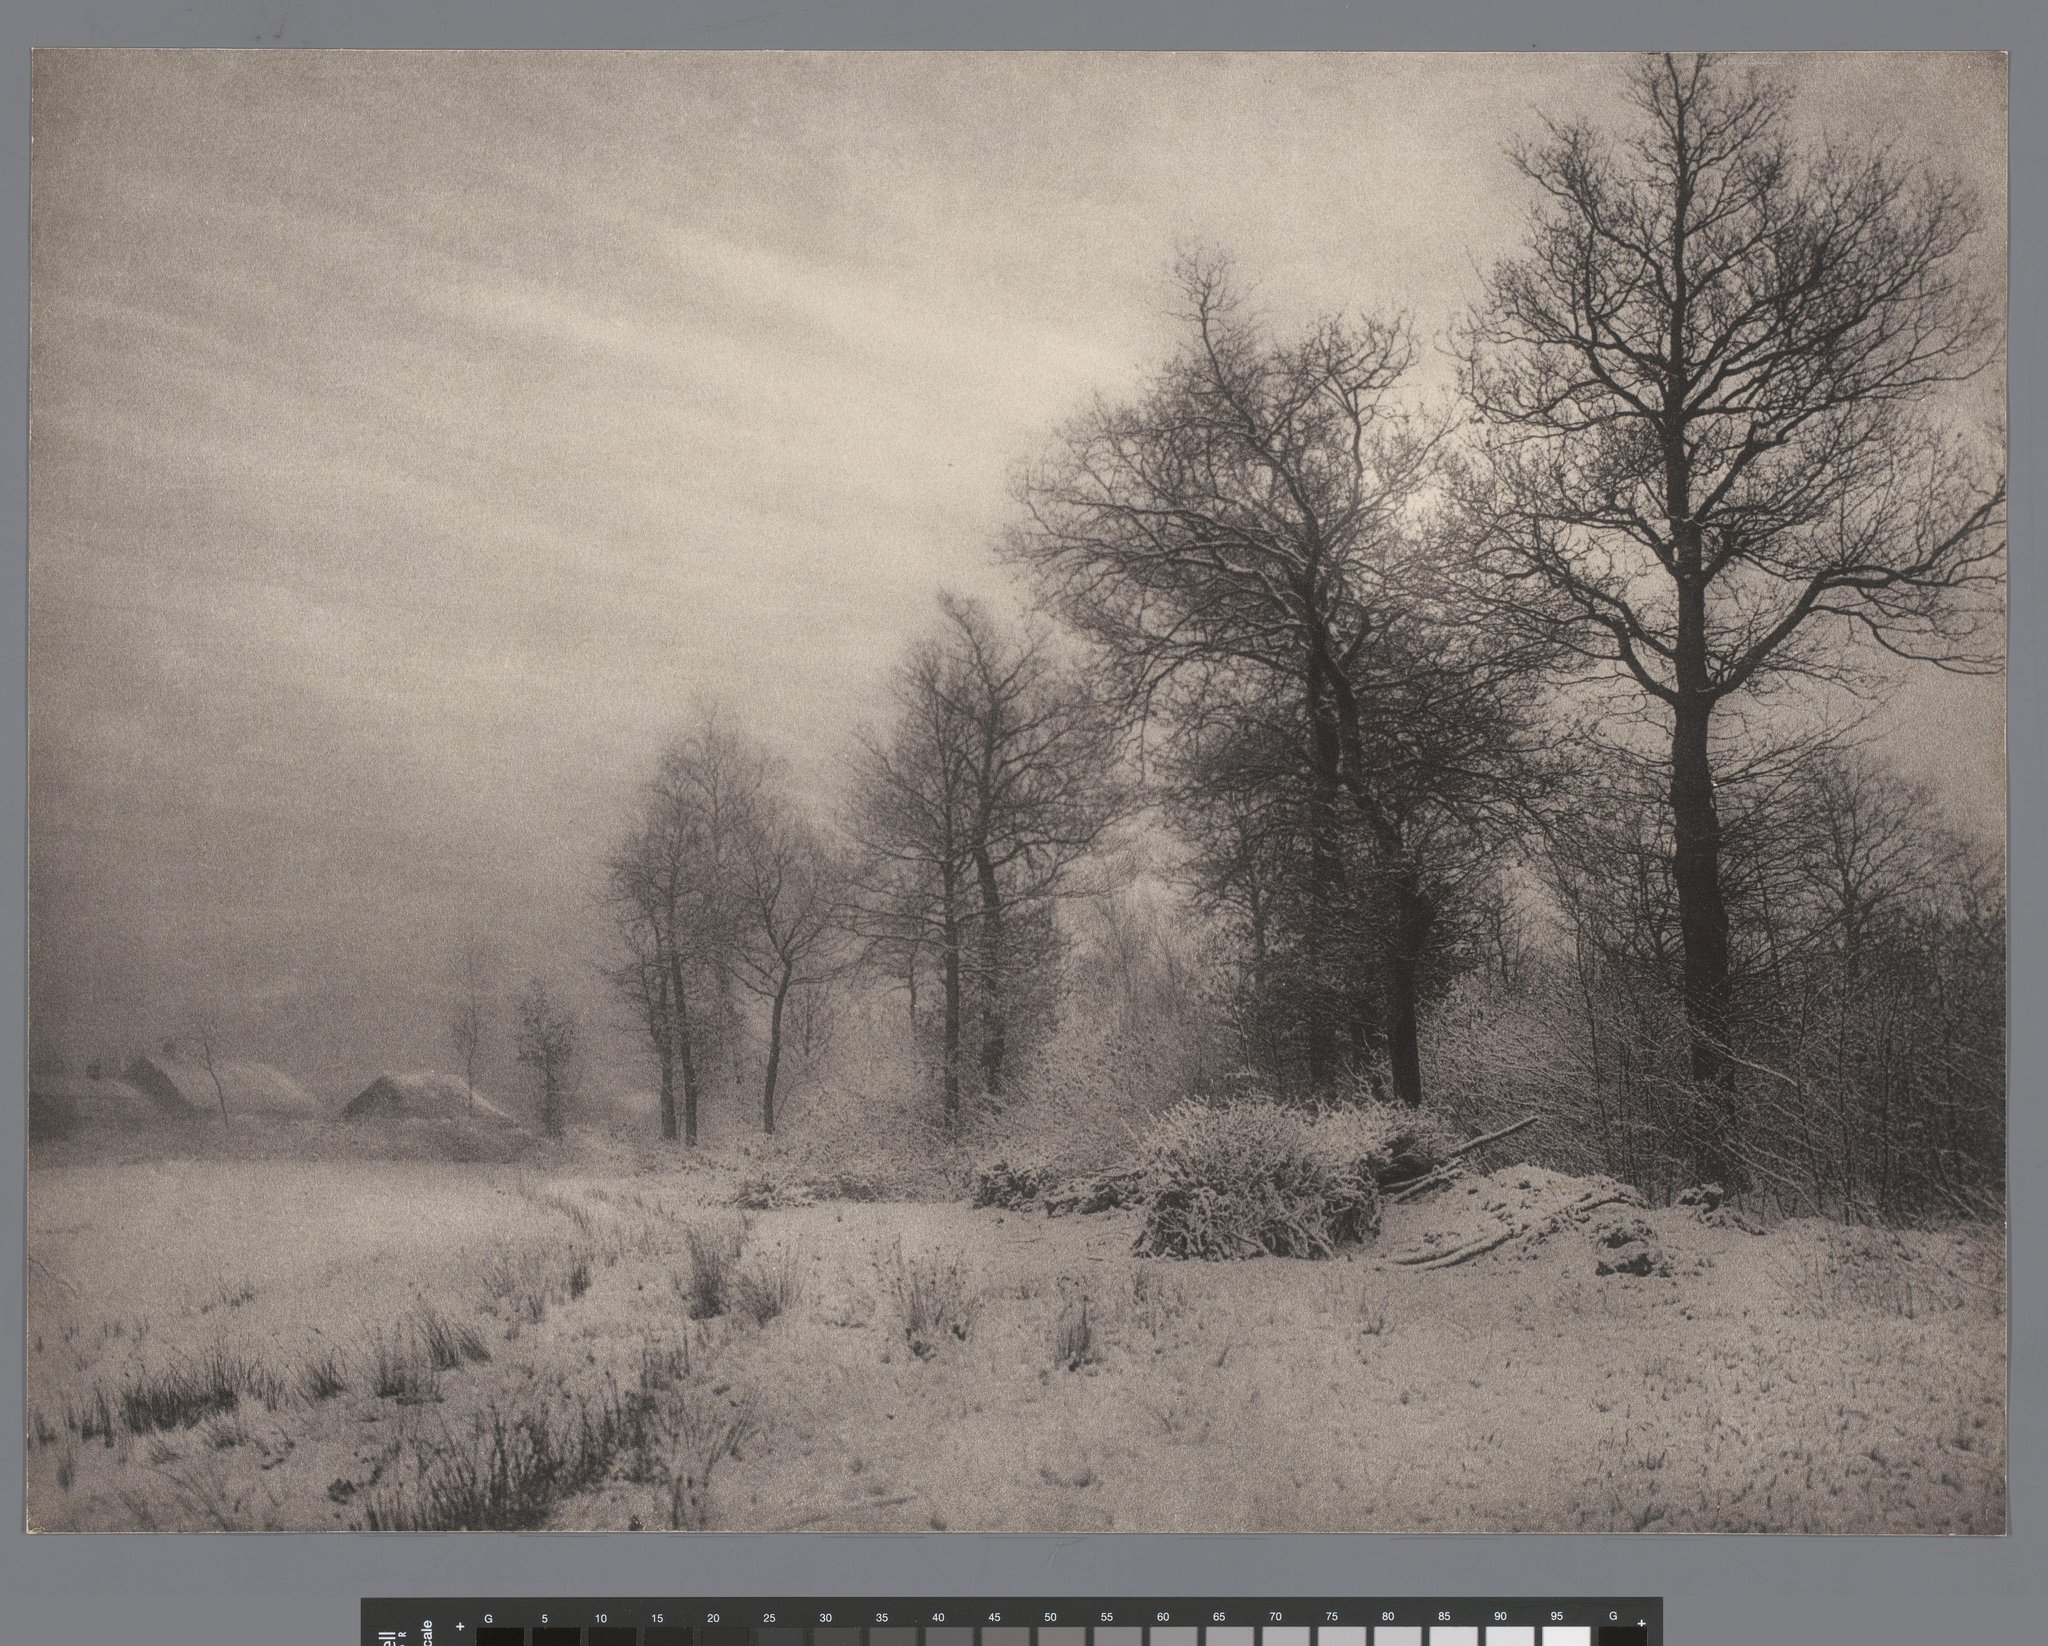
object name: photomechanical print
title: Landschap in de sneeuw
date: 1900-1918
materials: cardboard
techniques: photograph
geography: belgium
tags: winter landscape; landscape symbolizing winter (the four seasons of the year)